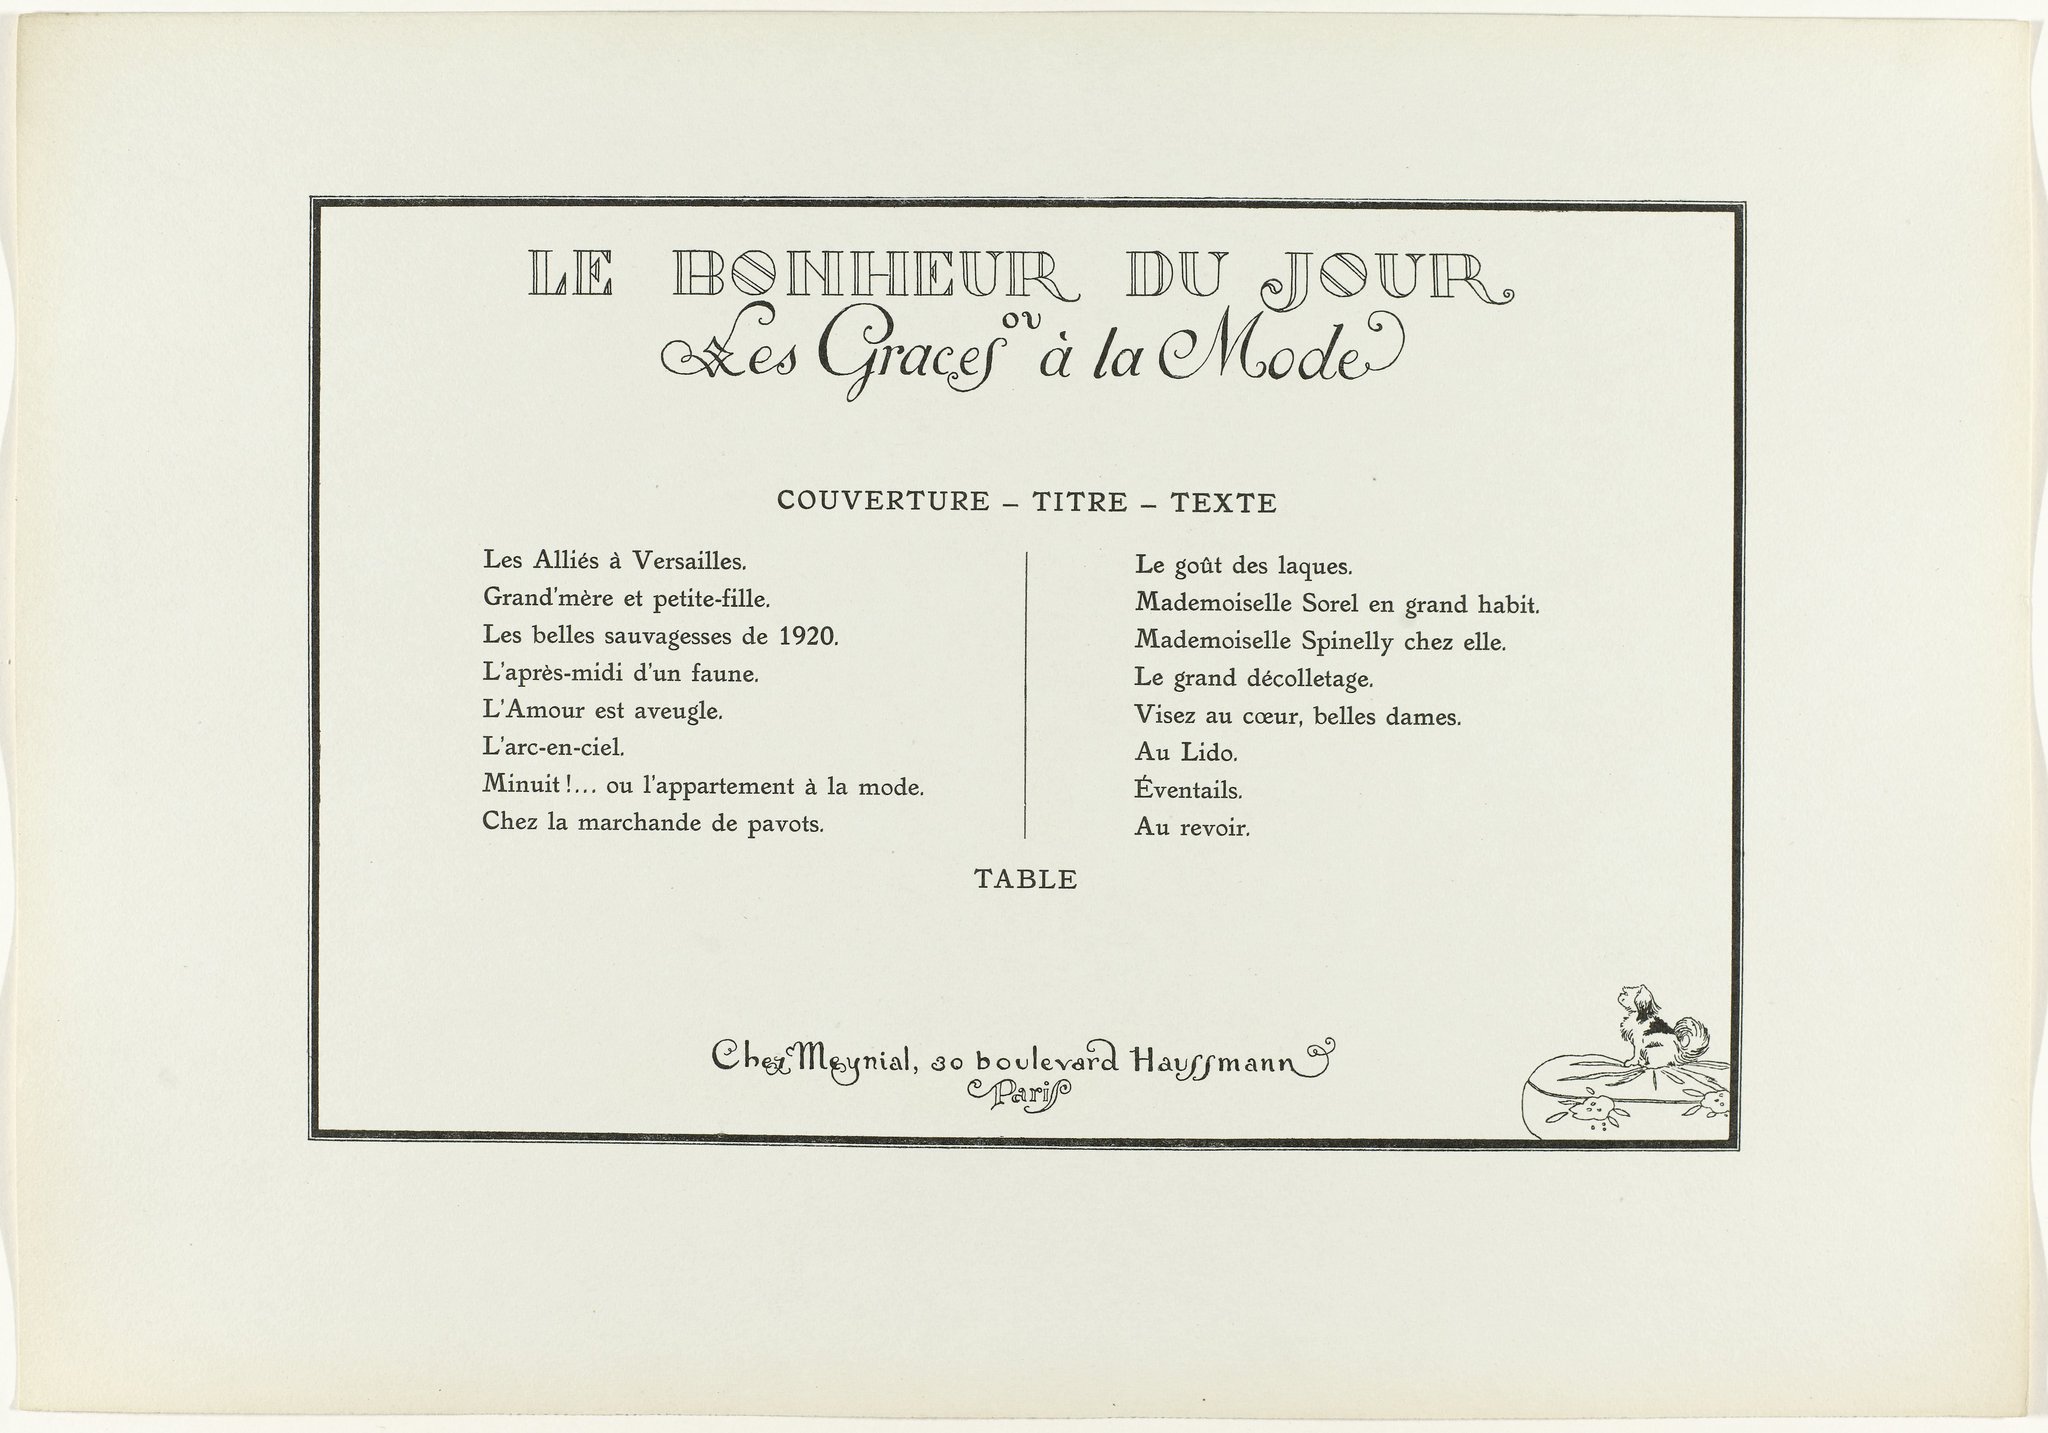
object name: fashion print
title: Le Bonheur du Jour ou Les Graces à la Mode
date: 1920-1924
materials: paper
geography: paris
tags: fashion plates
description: Index.Uit serie Le Bonheur du Jour ou Les Graces à la Mode.